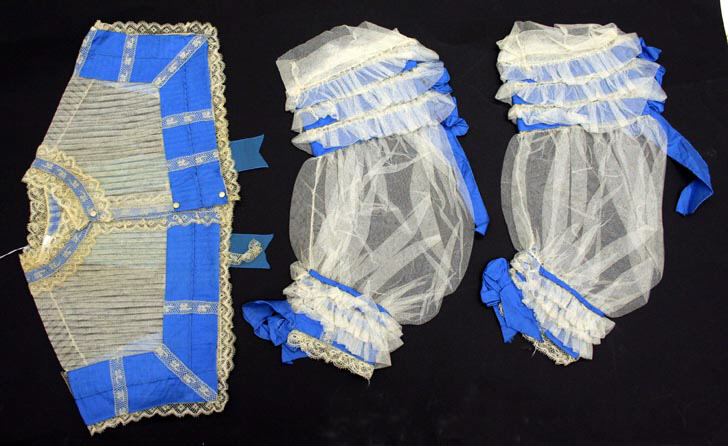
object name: accessory set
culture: american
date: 1860-1869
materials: cotton, silk